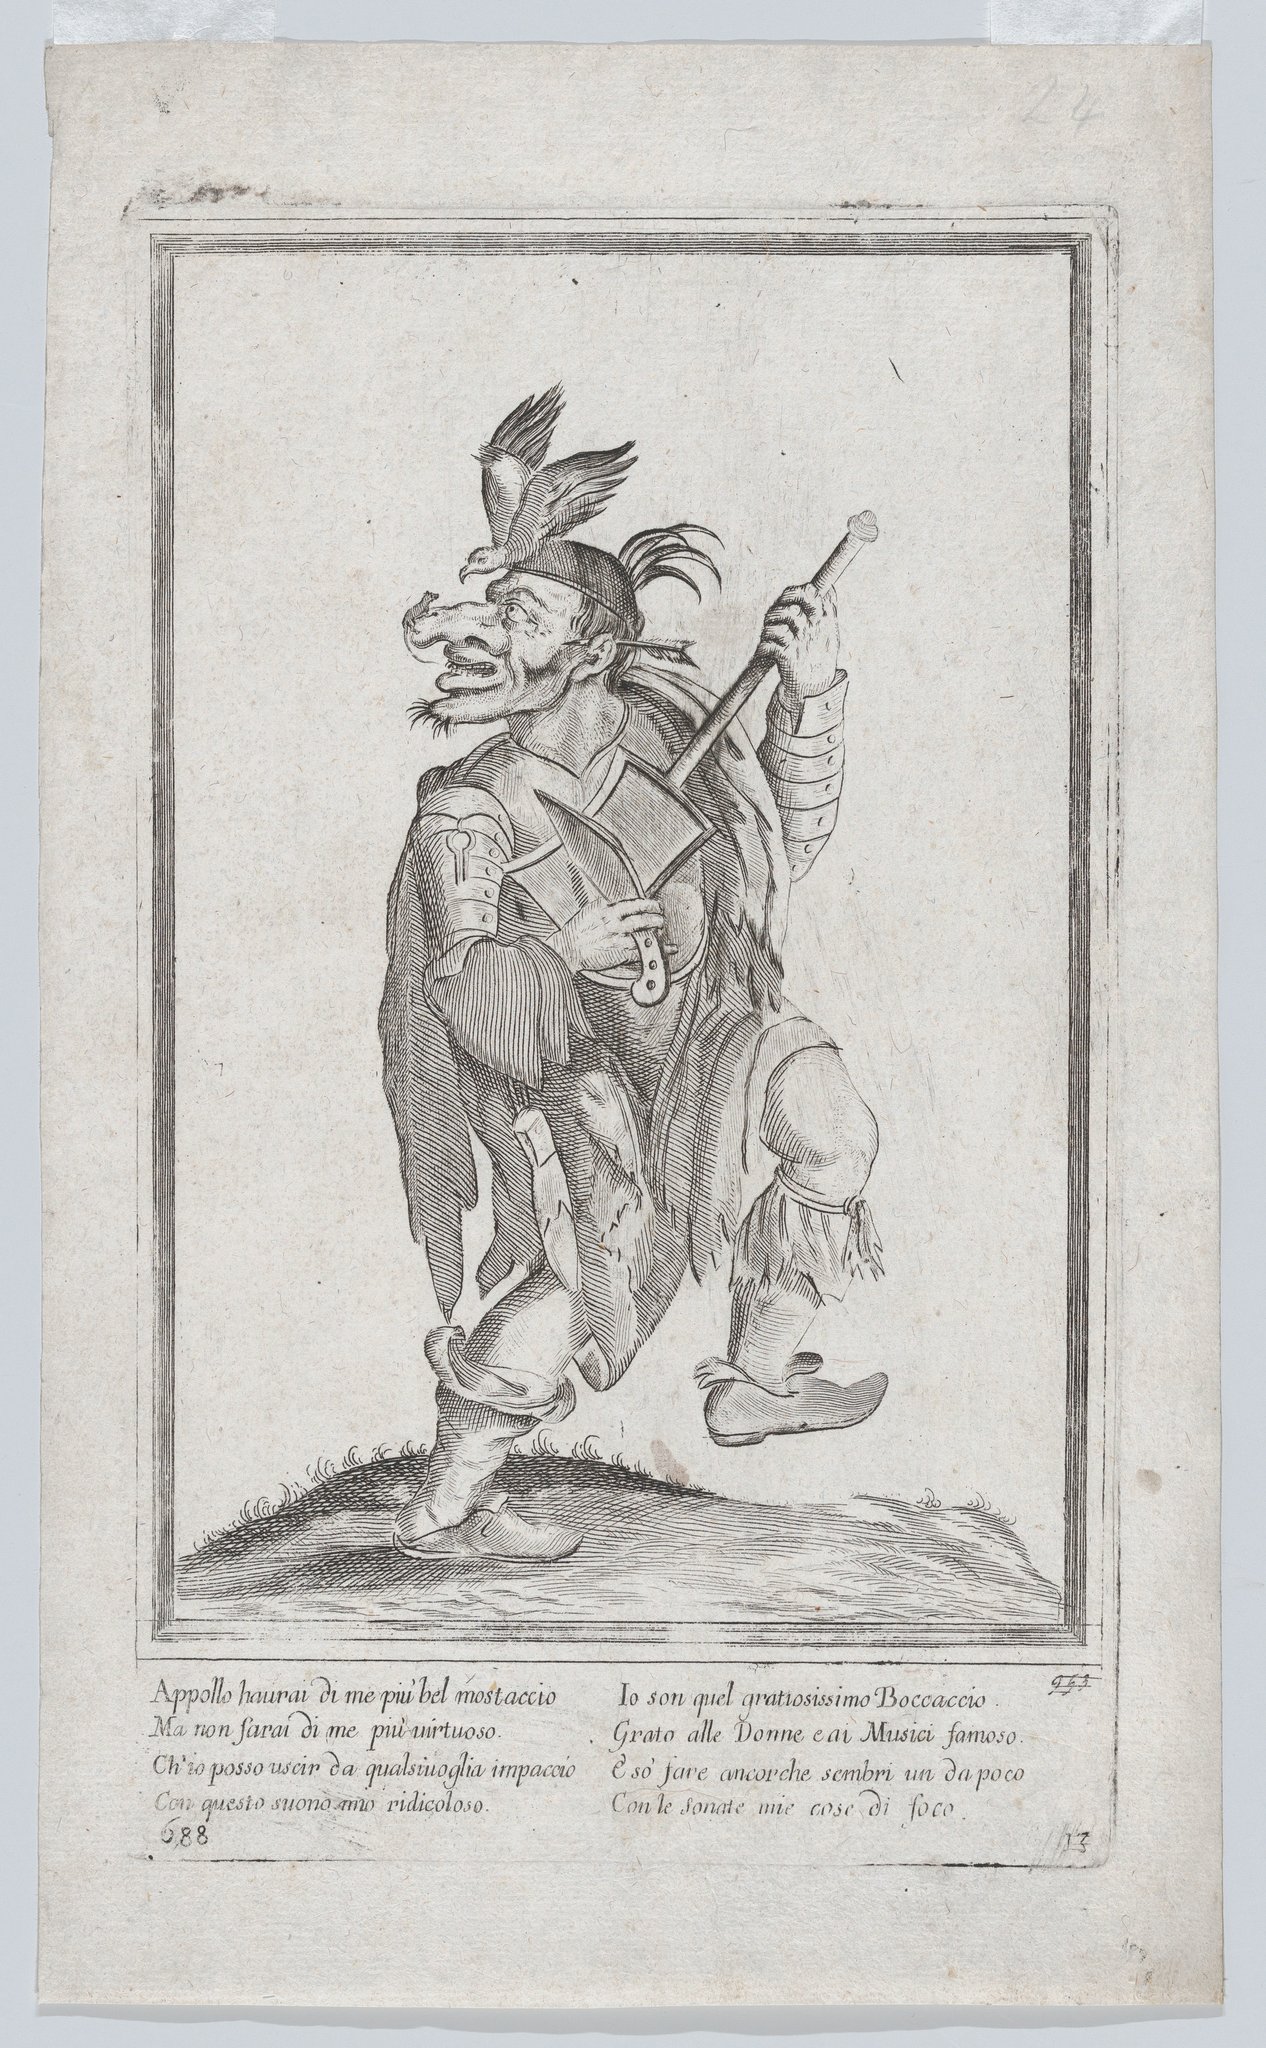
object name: print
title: A caricature figure representing a street musician(?) with a mouse (lizard?) on his nose and a bird on his head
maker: anonymous, italian, 17th century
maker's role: artist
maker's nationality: italian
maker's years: 1600-1700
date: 1640-1660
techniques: engraving, etching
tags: musical instruments,birds,men,mice,musicians